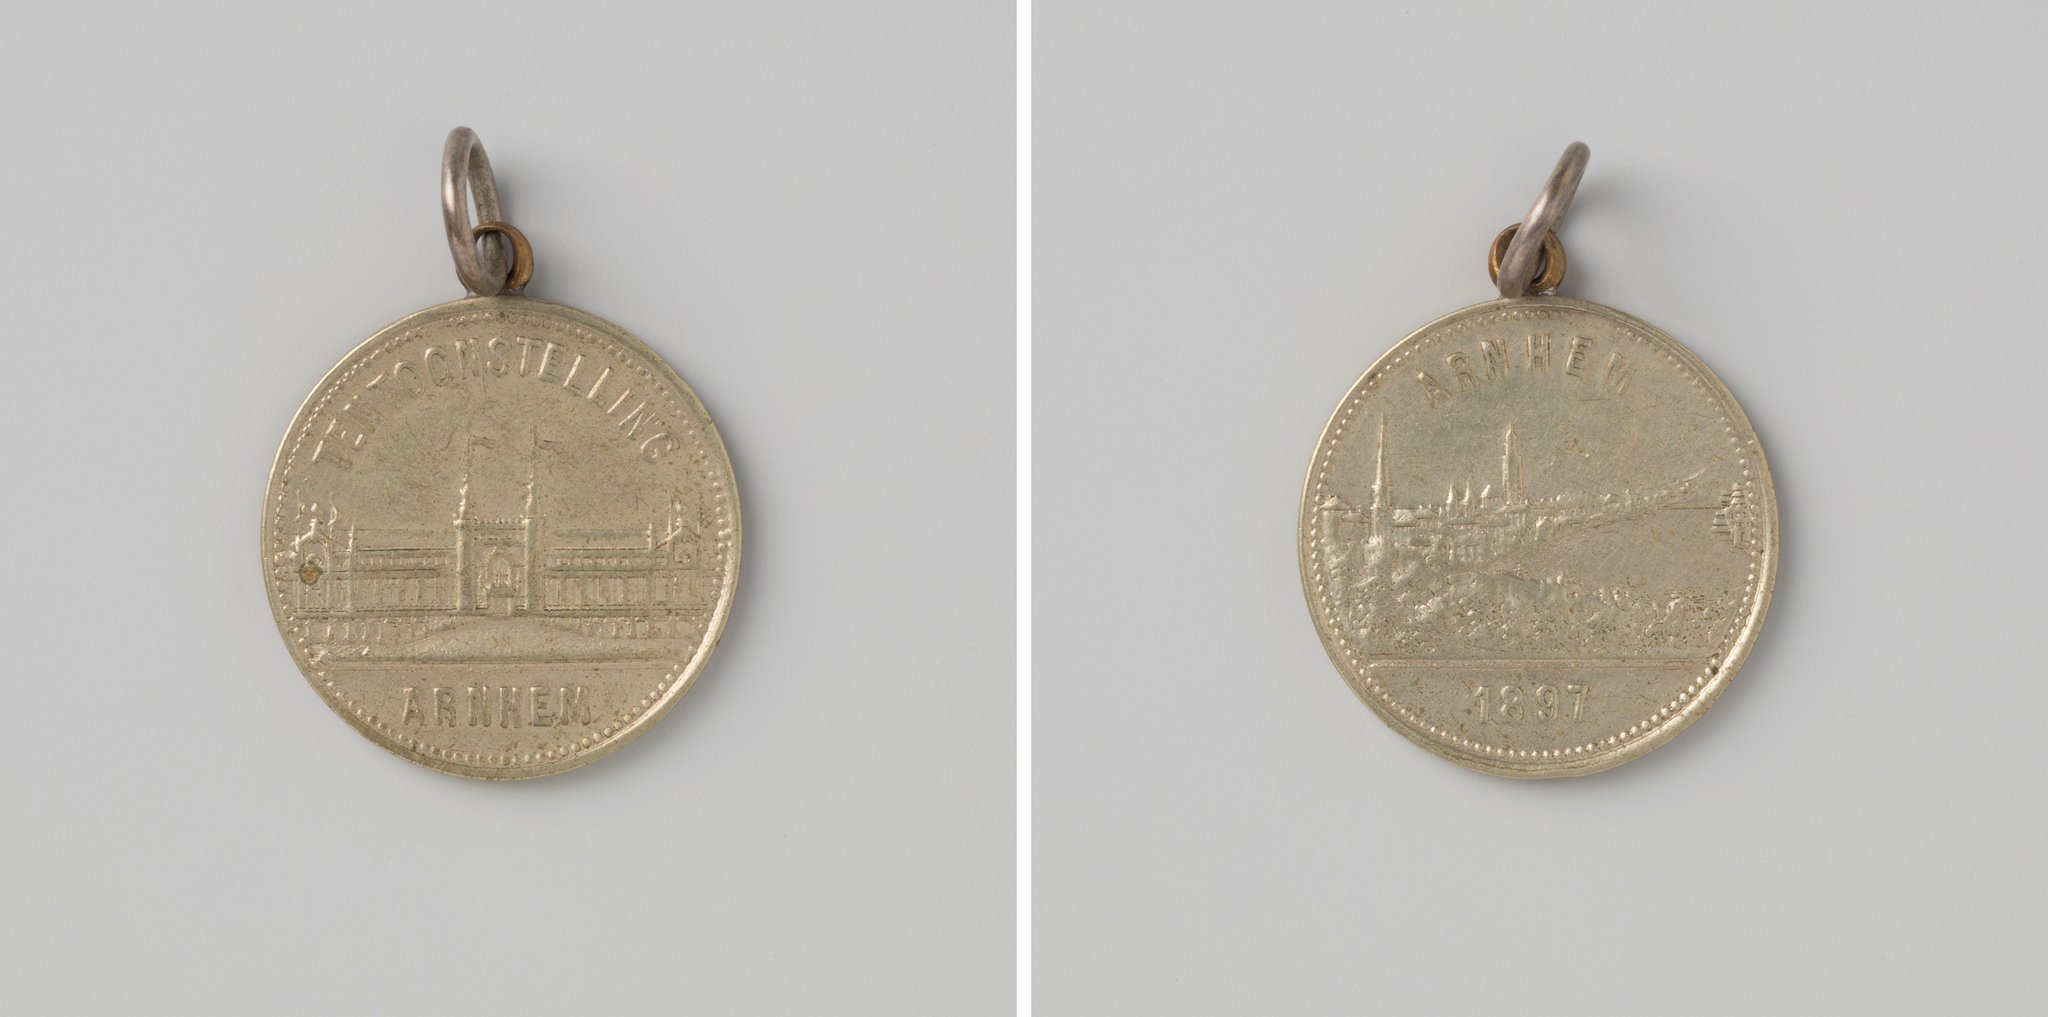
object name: medal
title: Tentoonstelling van Nijverheid en Handel te Arnhem 1897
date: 1897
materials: brass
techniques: striking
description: Verzilverde penning met oog en draagring, op de voorzijde het tentoonstellingsgebouw met omschrift bovenaan en afsnedetekst, op de keerzijde een stadsgezicht met omschrift bovenaan en afsnedetekst.